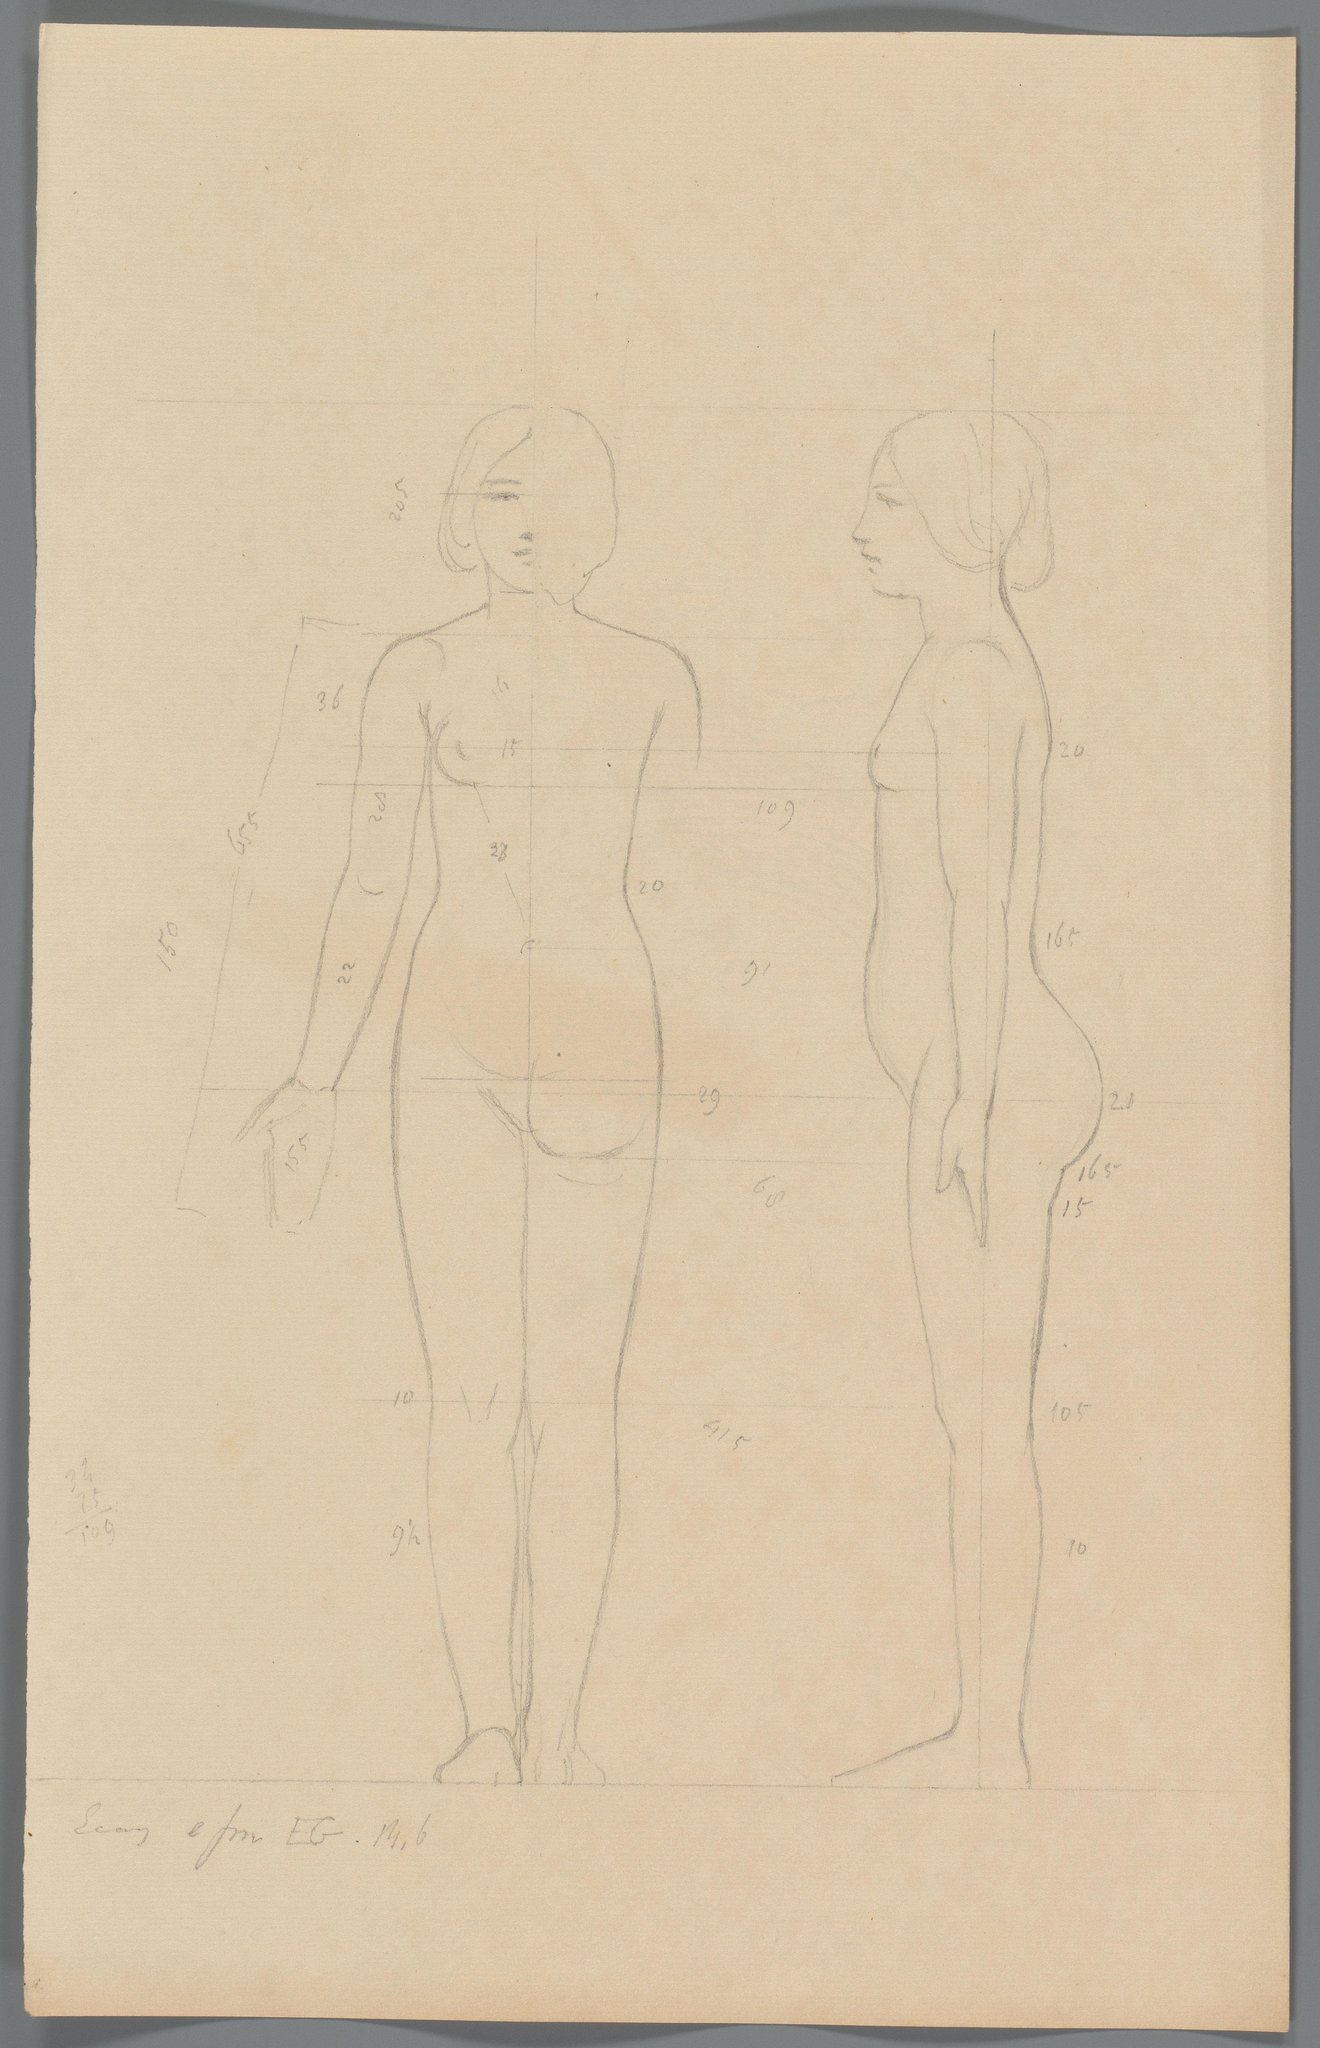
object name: drawing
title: Proportiestudie van een vrouw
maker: jacobus everhardus josephus van den berg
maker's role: draughtsman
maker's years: 1802-1861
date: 1857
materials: paper, pencil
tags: standing figure (canon, proportions) - aa - female human figure, anatomy (non-medical) - aa - female human figure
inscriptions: inscription: ‘[...] e fm EG [...]’